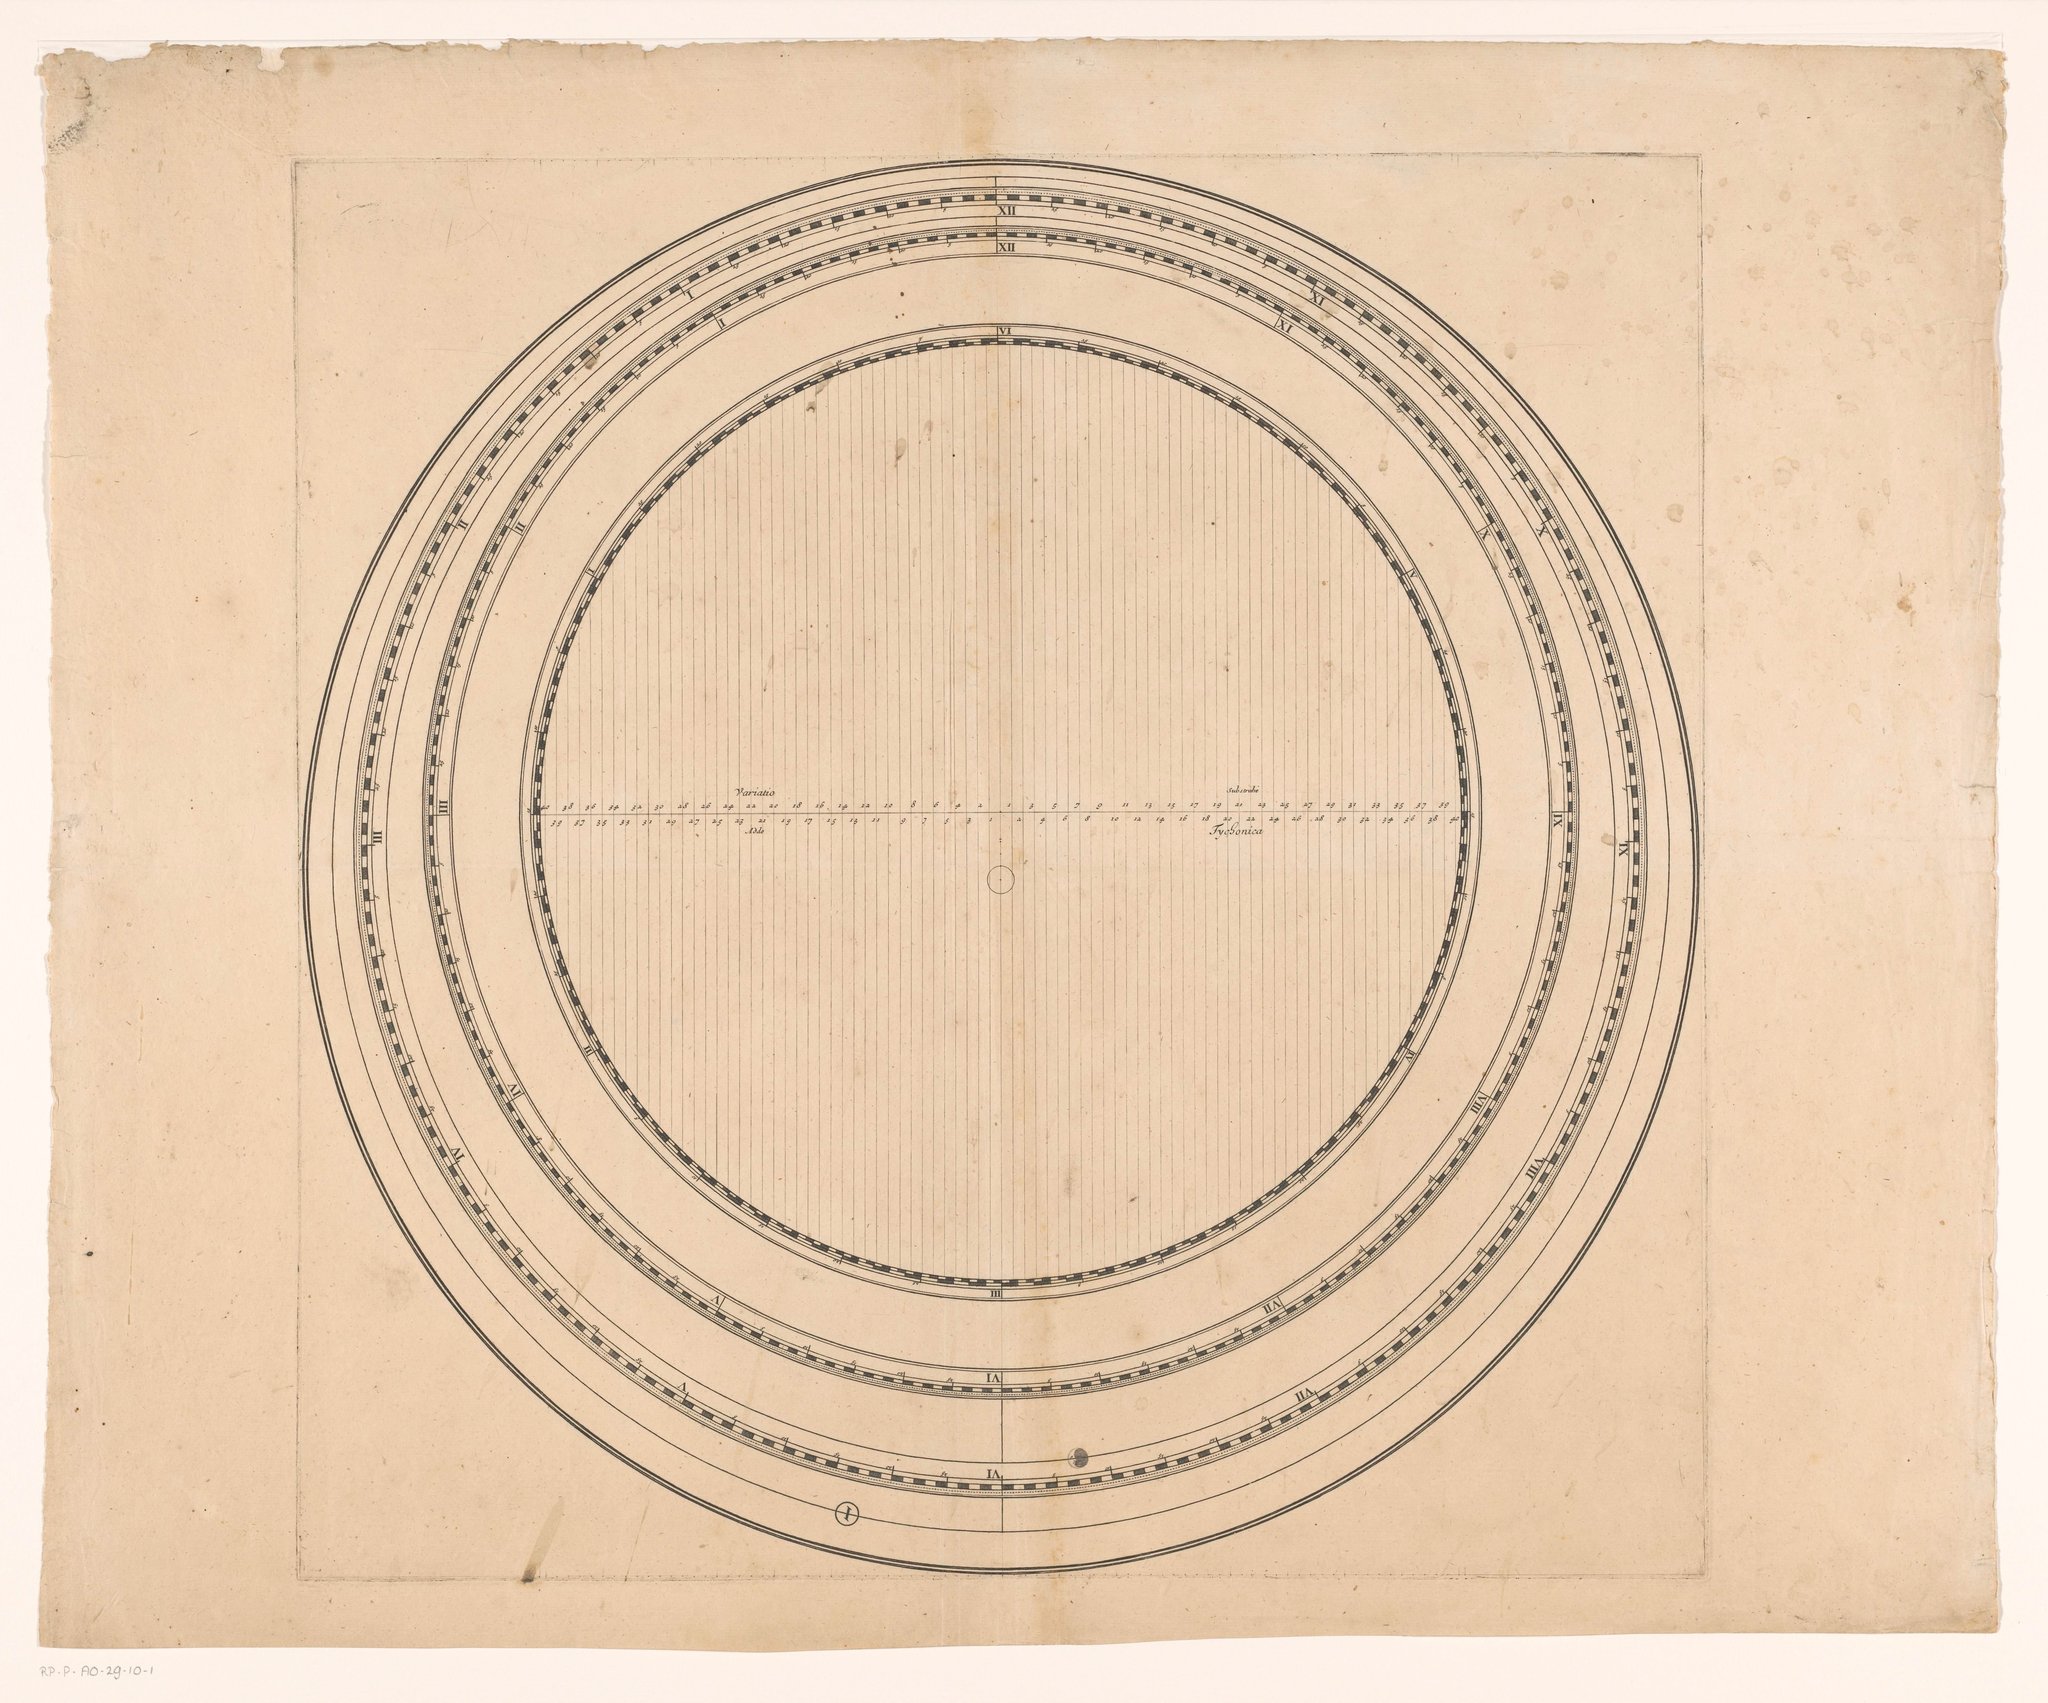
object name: map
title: Tweede blad van een driedelig beweegbaar planetarium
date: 1695-1726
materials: paper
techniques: engraving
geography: amsterdam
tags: zodiac; the twelve zodiacal signs together, planets; planetary system, solar system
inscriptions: collector's mark: Lugt 2228